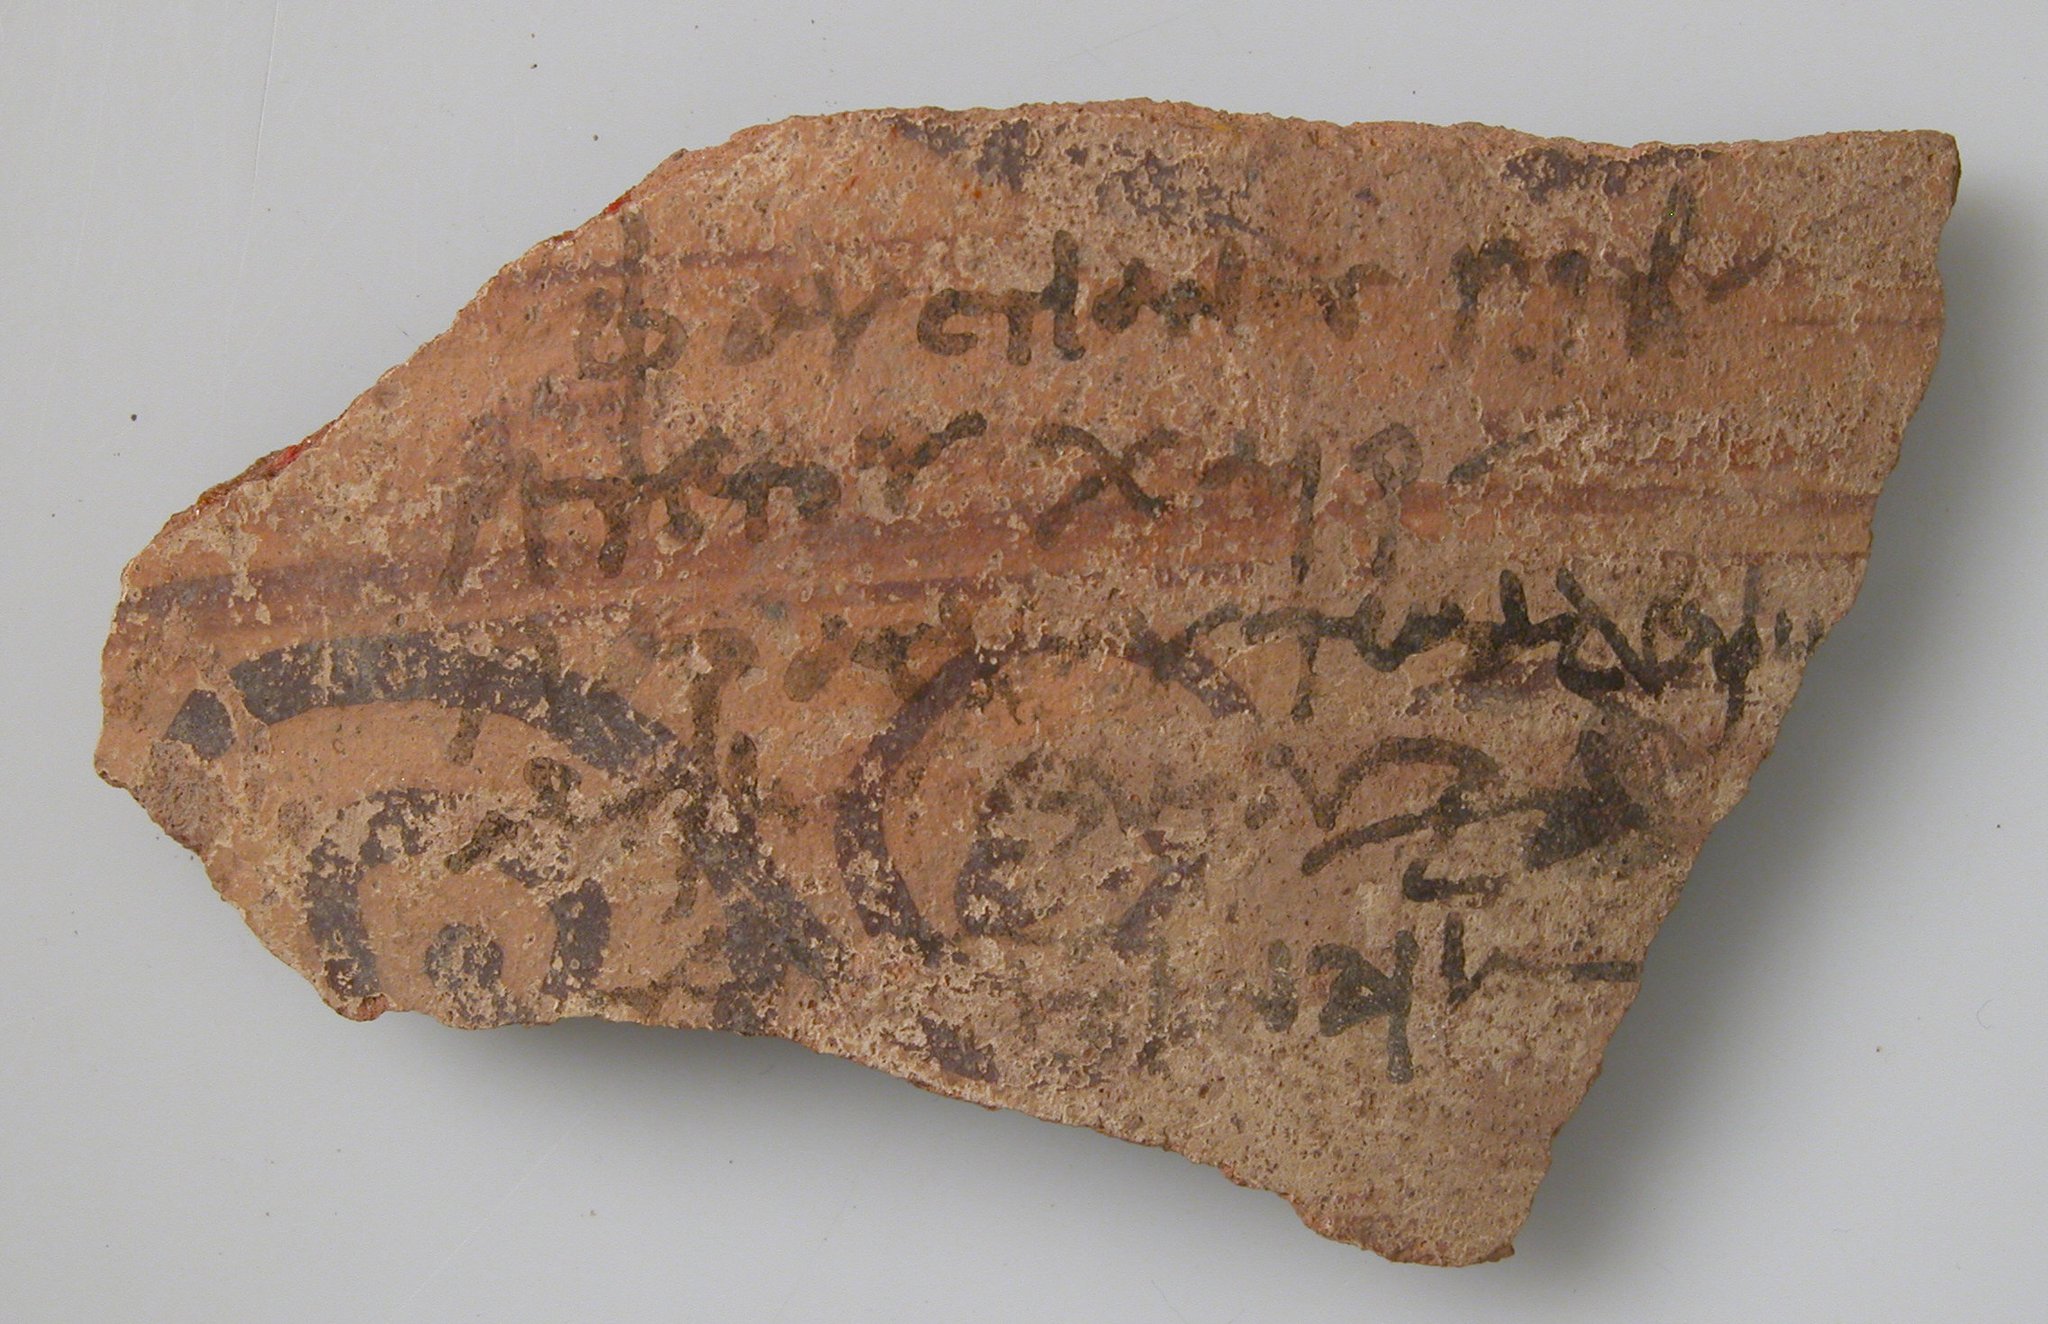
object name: ostrakon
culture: coptic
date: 301-700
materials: ink, pottery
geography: egypt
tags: documents